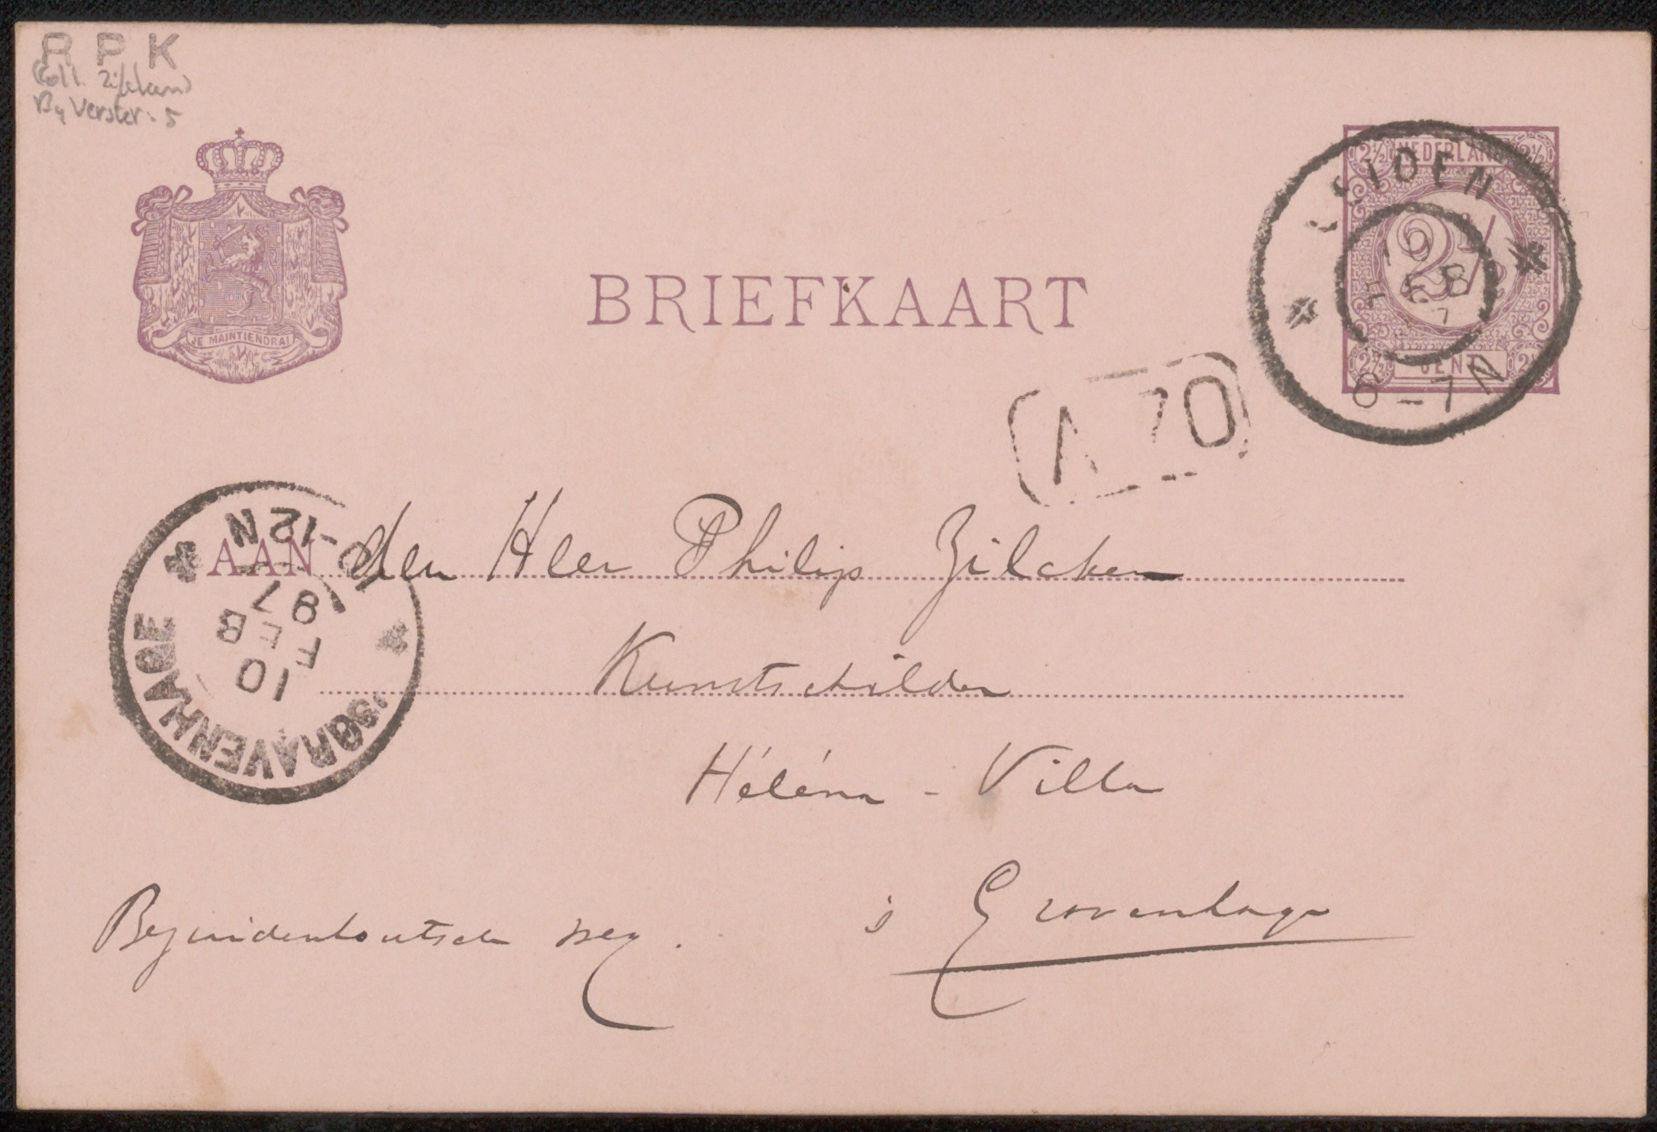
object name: postcard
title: Briefkaart aan Philip Zilcken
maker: cees verster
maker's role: conservator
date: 1897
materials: cardboard, ink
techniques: pen, writing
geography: leiden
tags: publisher, painter, draughtsman, philip zilcken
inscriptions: collector's mark: ‘RPK’